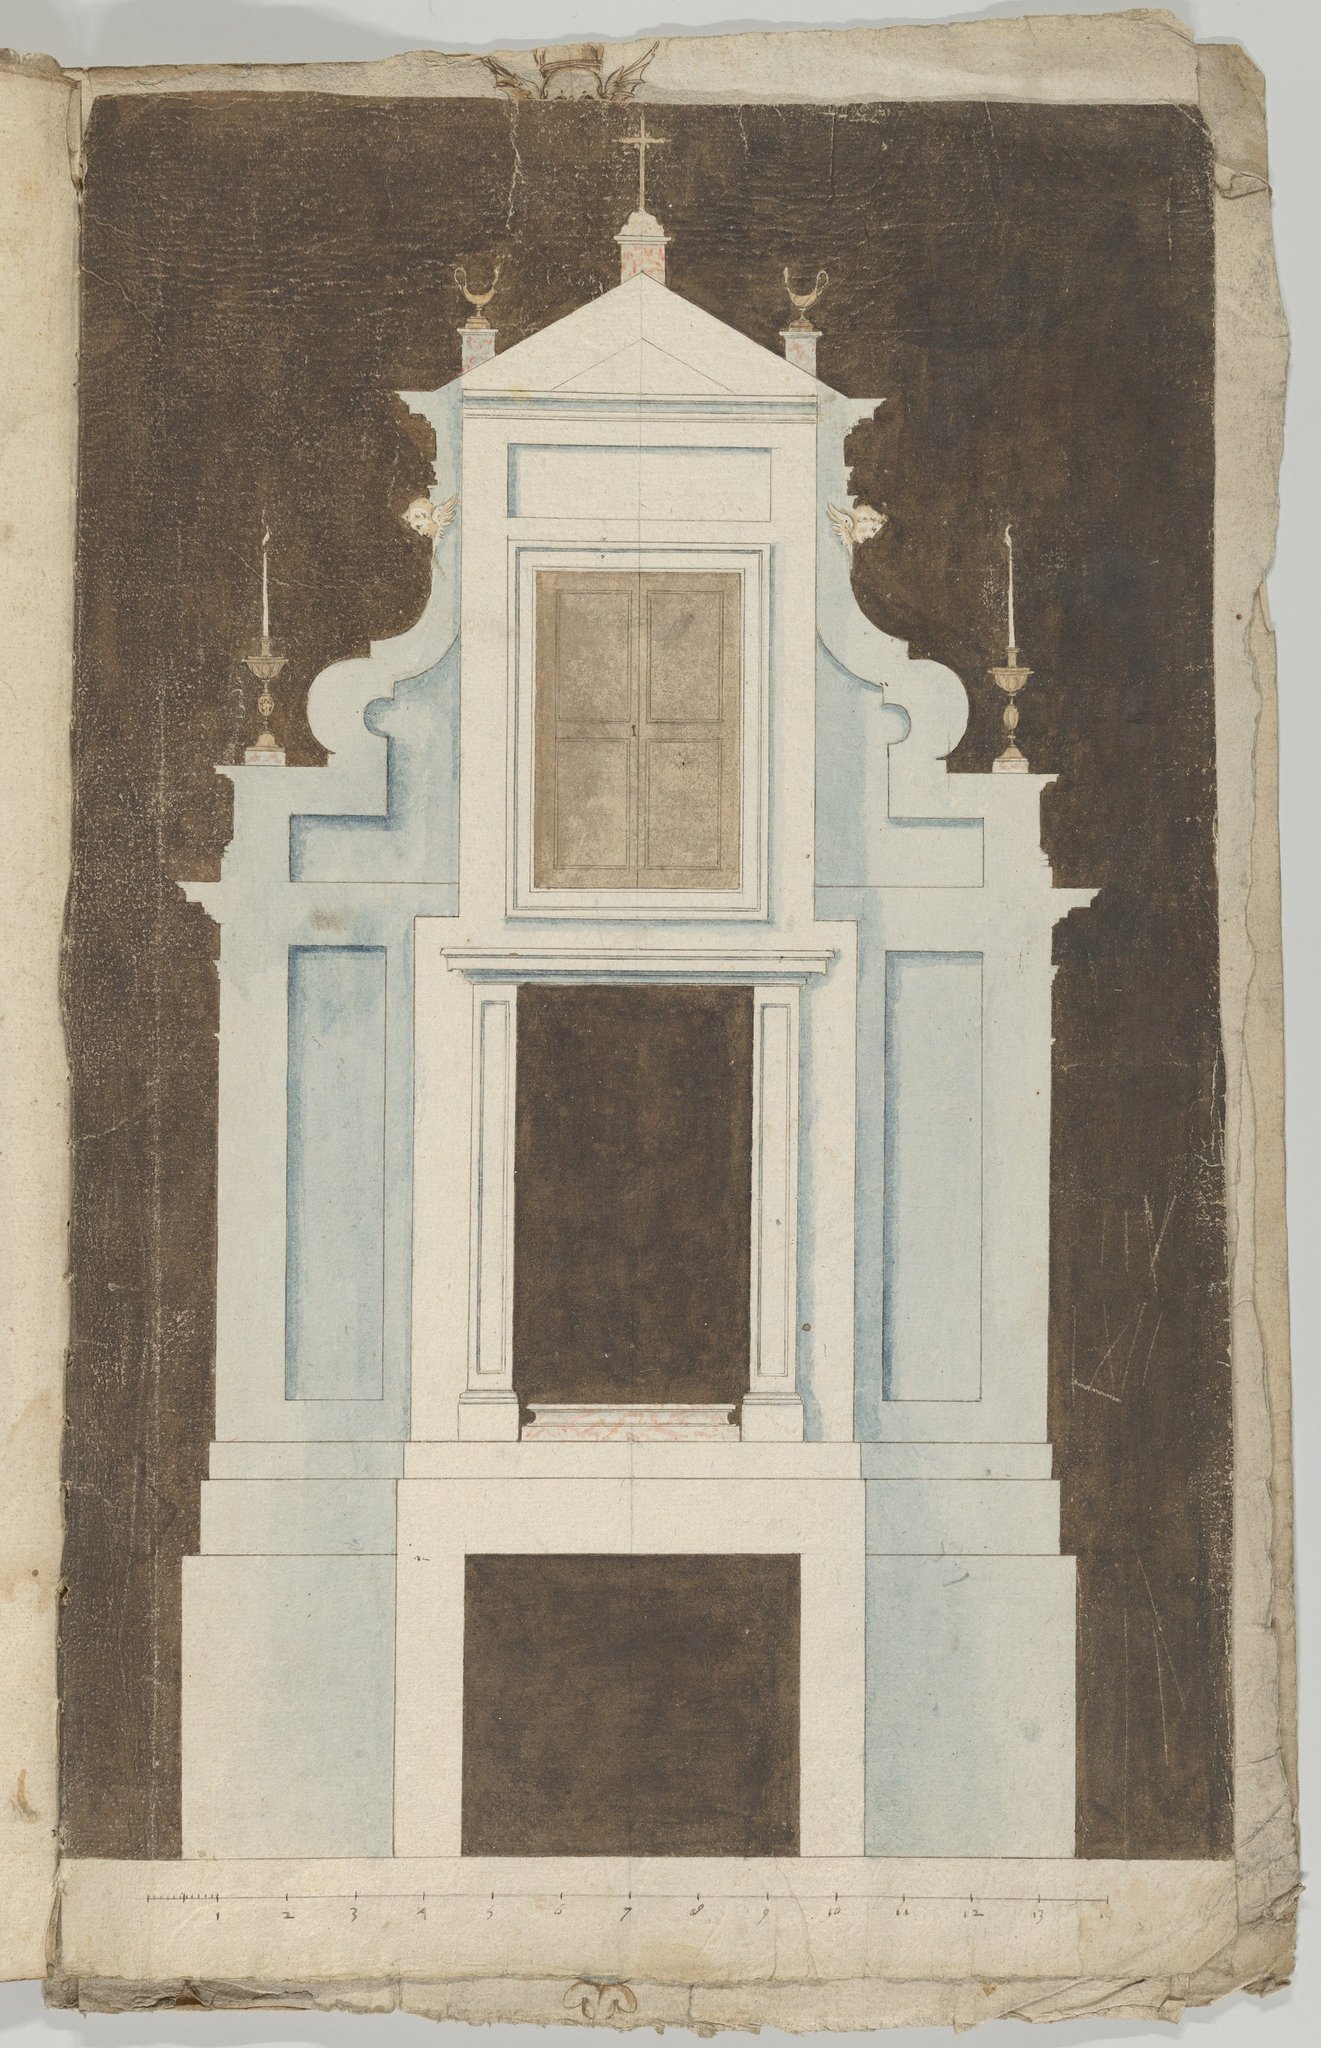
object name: drawing ornament architecture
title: Design for an Altar or Wall Tomb in a Blue-Gray Stone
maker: anonymous, flemish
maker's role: artist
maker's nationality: flemish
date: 1601-1700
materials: ink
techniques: pen, wash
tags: architecture,altars,cross